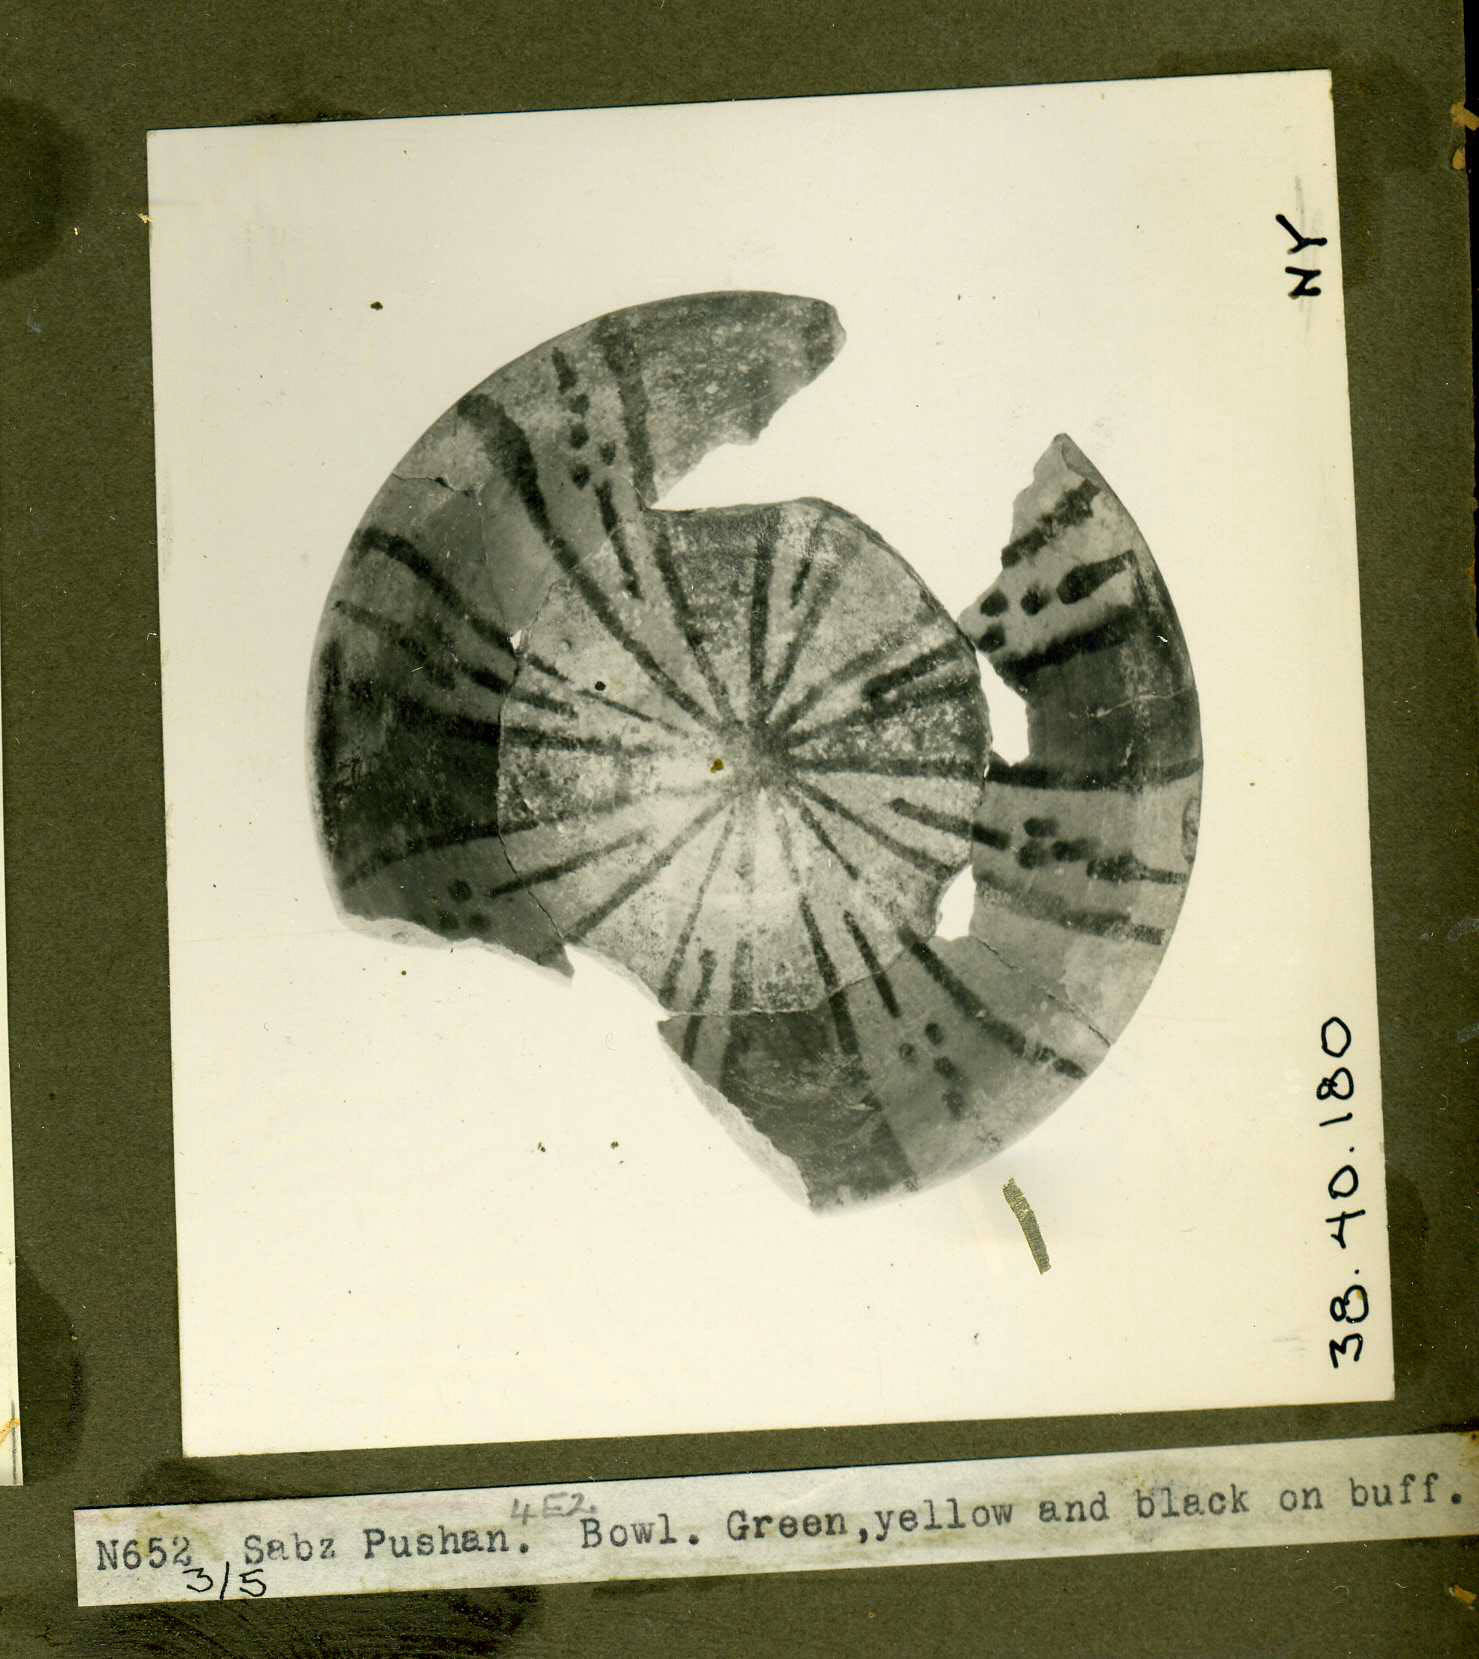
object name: bowl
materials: earthenware, glaze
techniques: polychrome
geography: iran